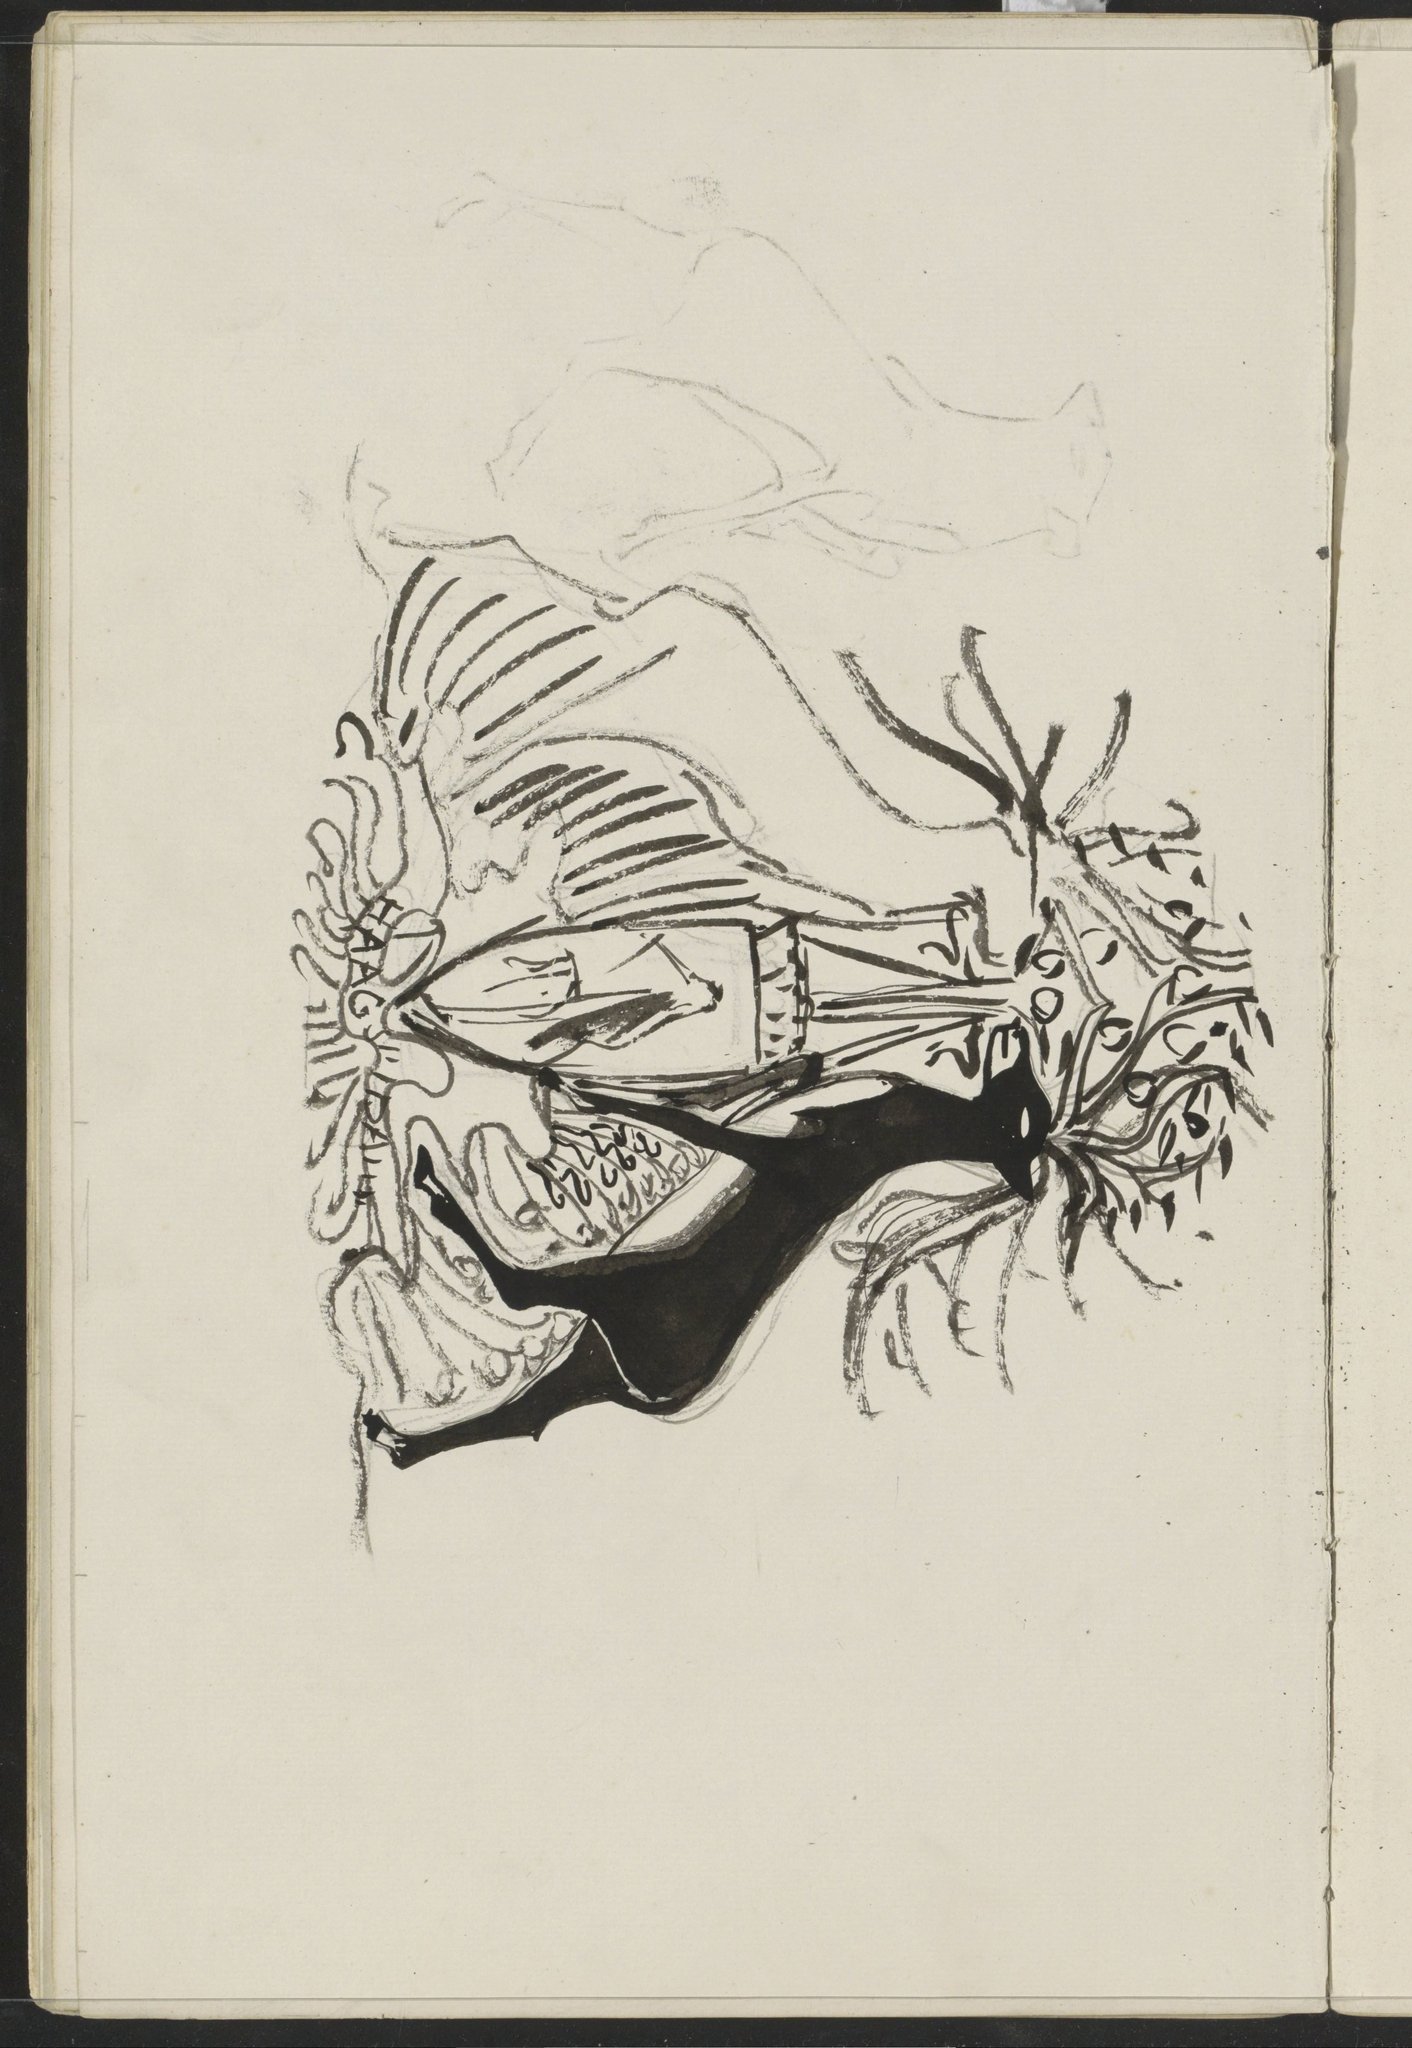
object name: sketchbook leaf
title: Ontwerp met een dier bij een boom en een wapenschild met een ooievaar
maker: carel adolph lion cachet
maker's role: draughtsman, print maker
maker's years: 1864-1945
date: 1897-1898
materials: chalk, ink, paper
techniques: brush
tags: printed matter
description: Blad 24 verso uit een schetsboek met 29 bladen.